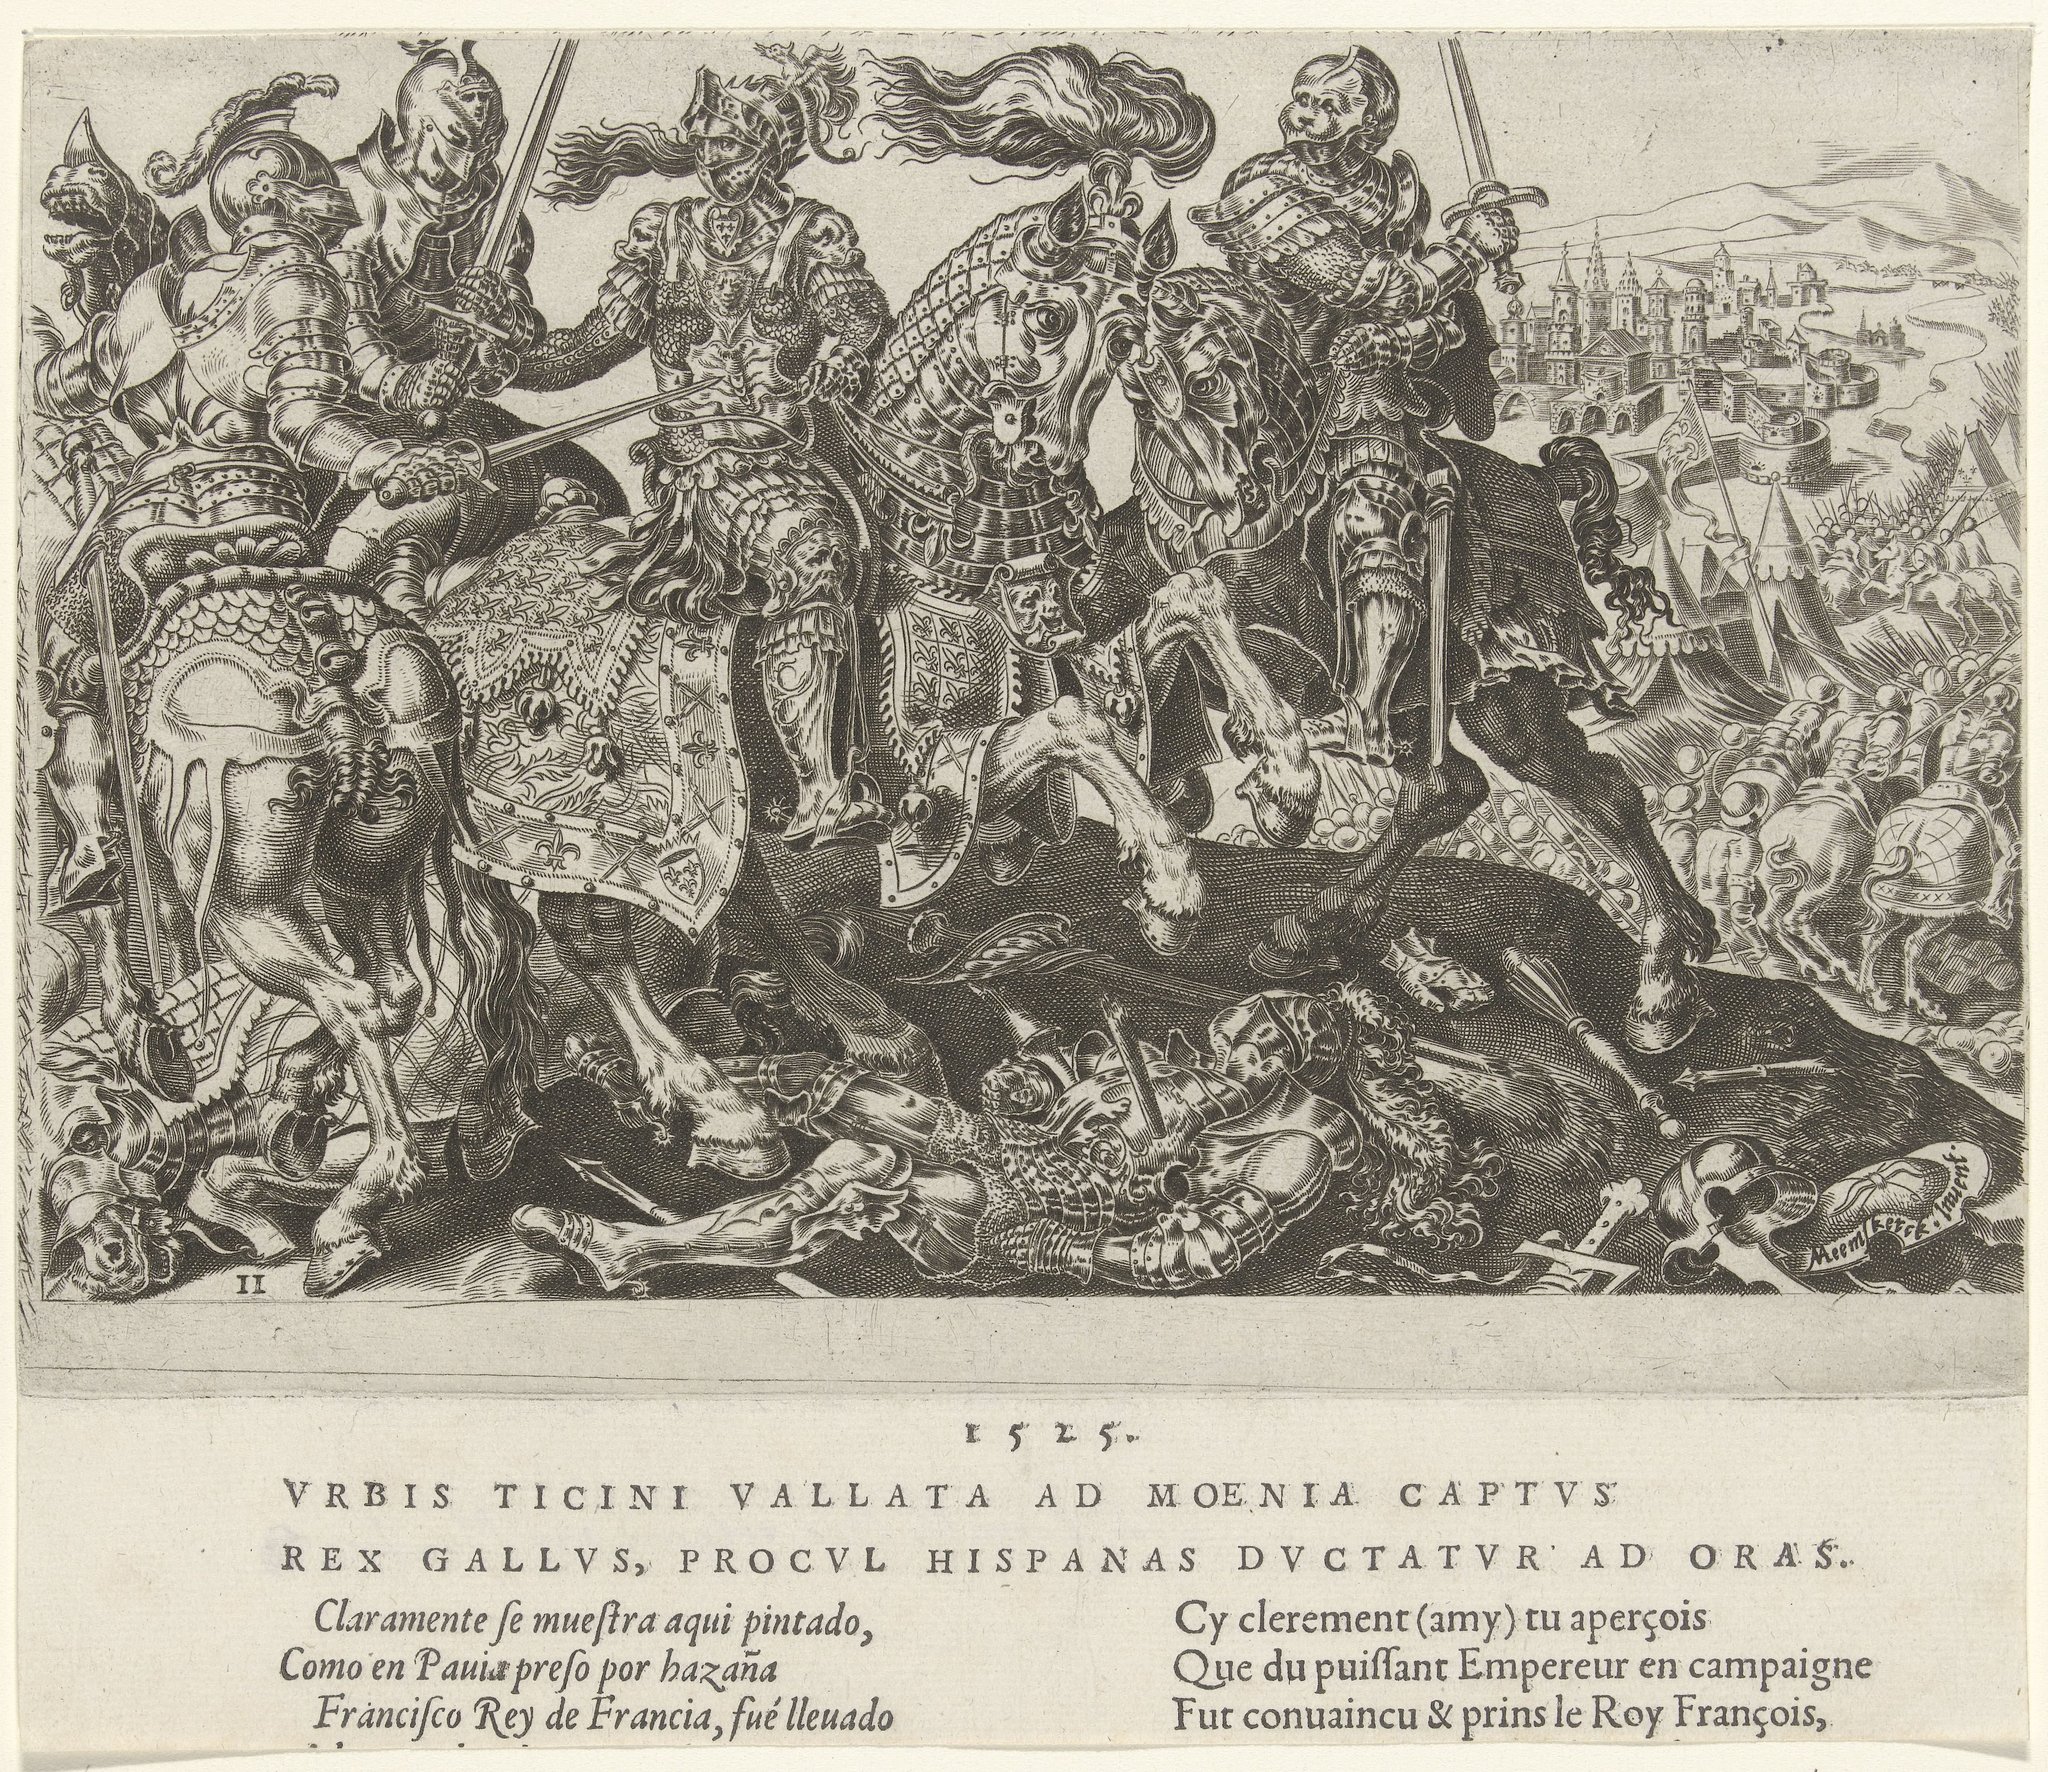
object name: print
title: Gevangename van Frans I tijdens de slag van Pavia, 1525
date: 1555-1556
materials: paper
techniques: engraving, etching, letterpress printing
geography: antwerp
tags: frans i van valois-angoulême (koning van frankrijk), ghent, charles v (holy roman emperor and king of spain), battle (+ cavalry, horsemen)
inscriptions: collector's mark: Lugt 2228, collector's mark: Lugt 2760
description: De gevangenname van Frans I, koning van Frankrijk, tijdens de slag bij Pavia (1525). De koning te paard wordt omringd door drie ridders, eveneens te paard. Op de voorgrond ligt het lichaam van een verslagen ridder. Op de achtergrondtenten en legers met in de verte de stad Pavia. De prent heeft een Latijns, Spaans en Frans onderschrift en maakt deel uit van een twaalfdelige serie over de overwinningen van Karel V.